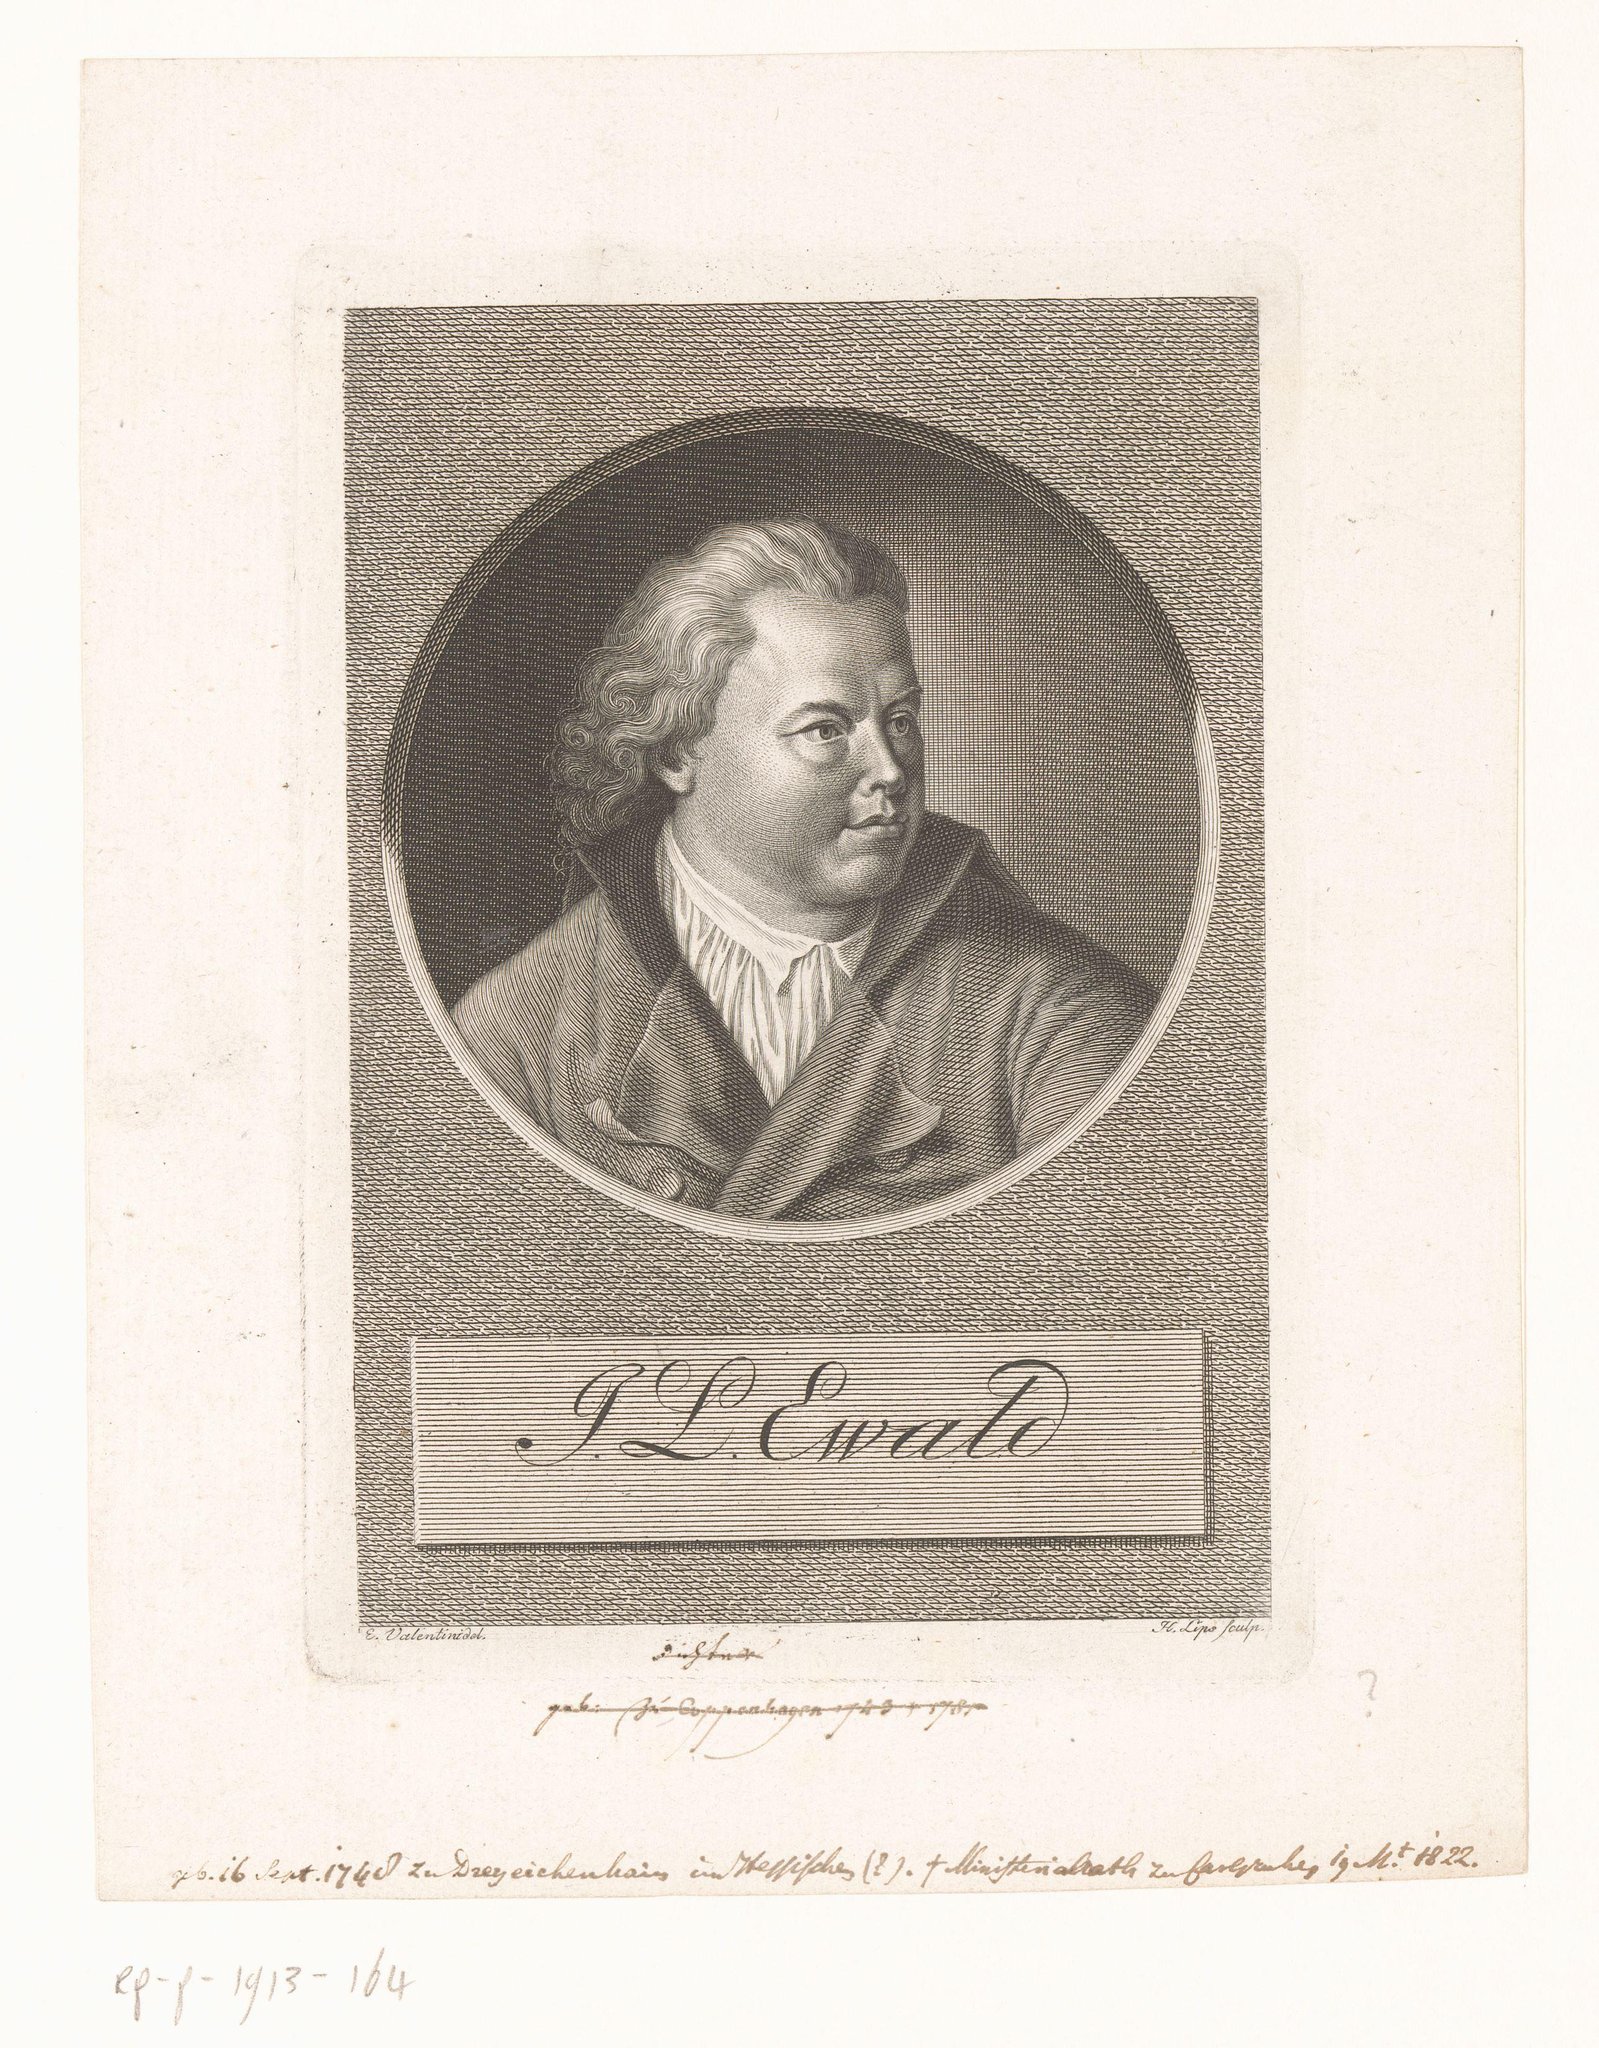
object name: print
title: Portret van Johann Ludwig Ewald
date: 1768-1817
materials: paper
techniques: engraving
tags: theologian, historical persons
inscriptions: collector's mark: Lugt 2228